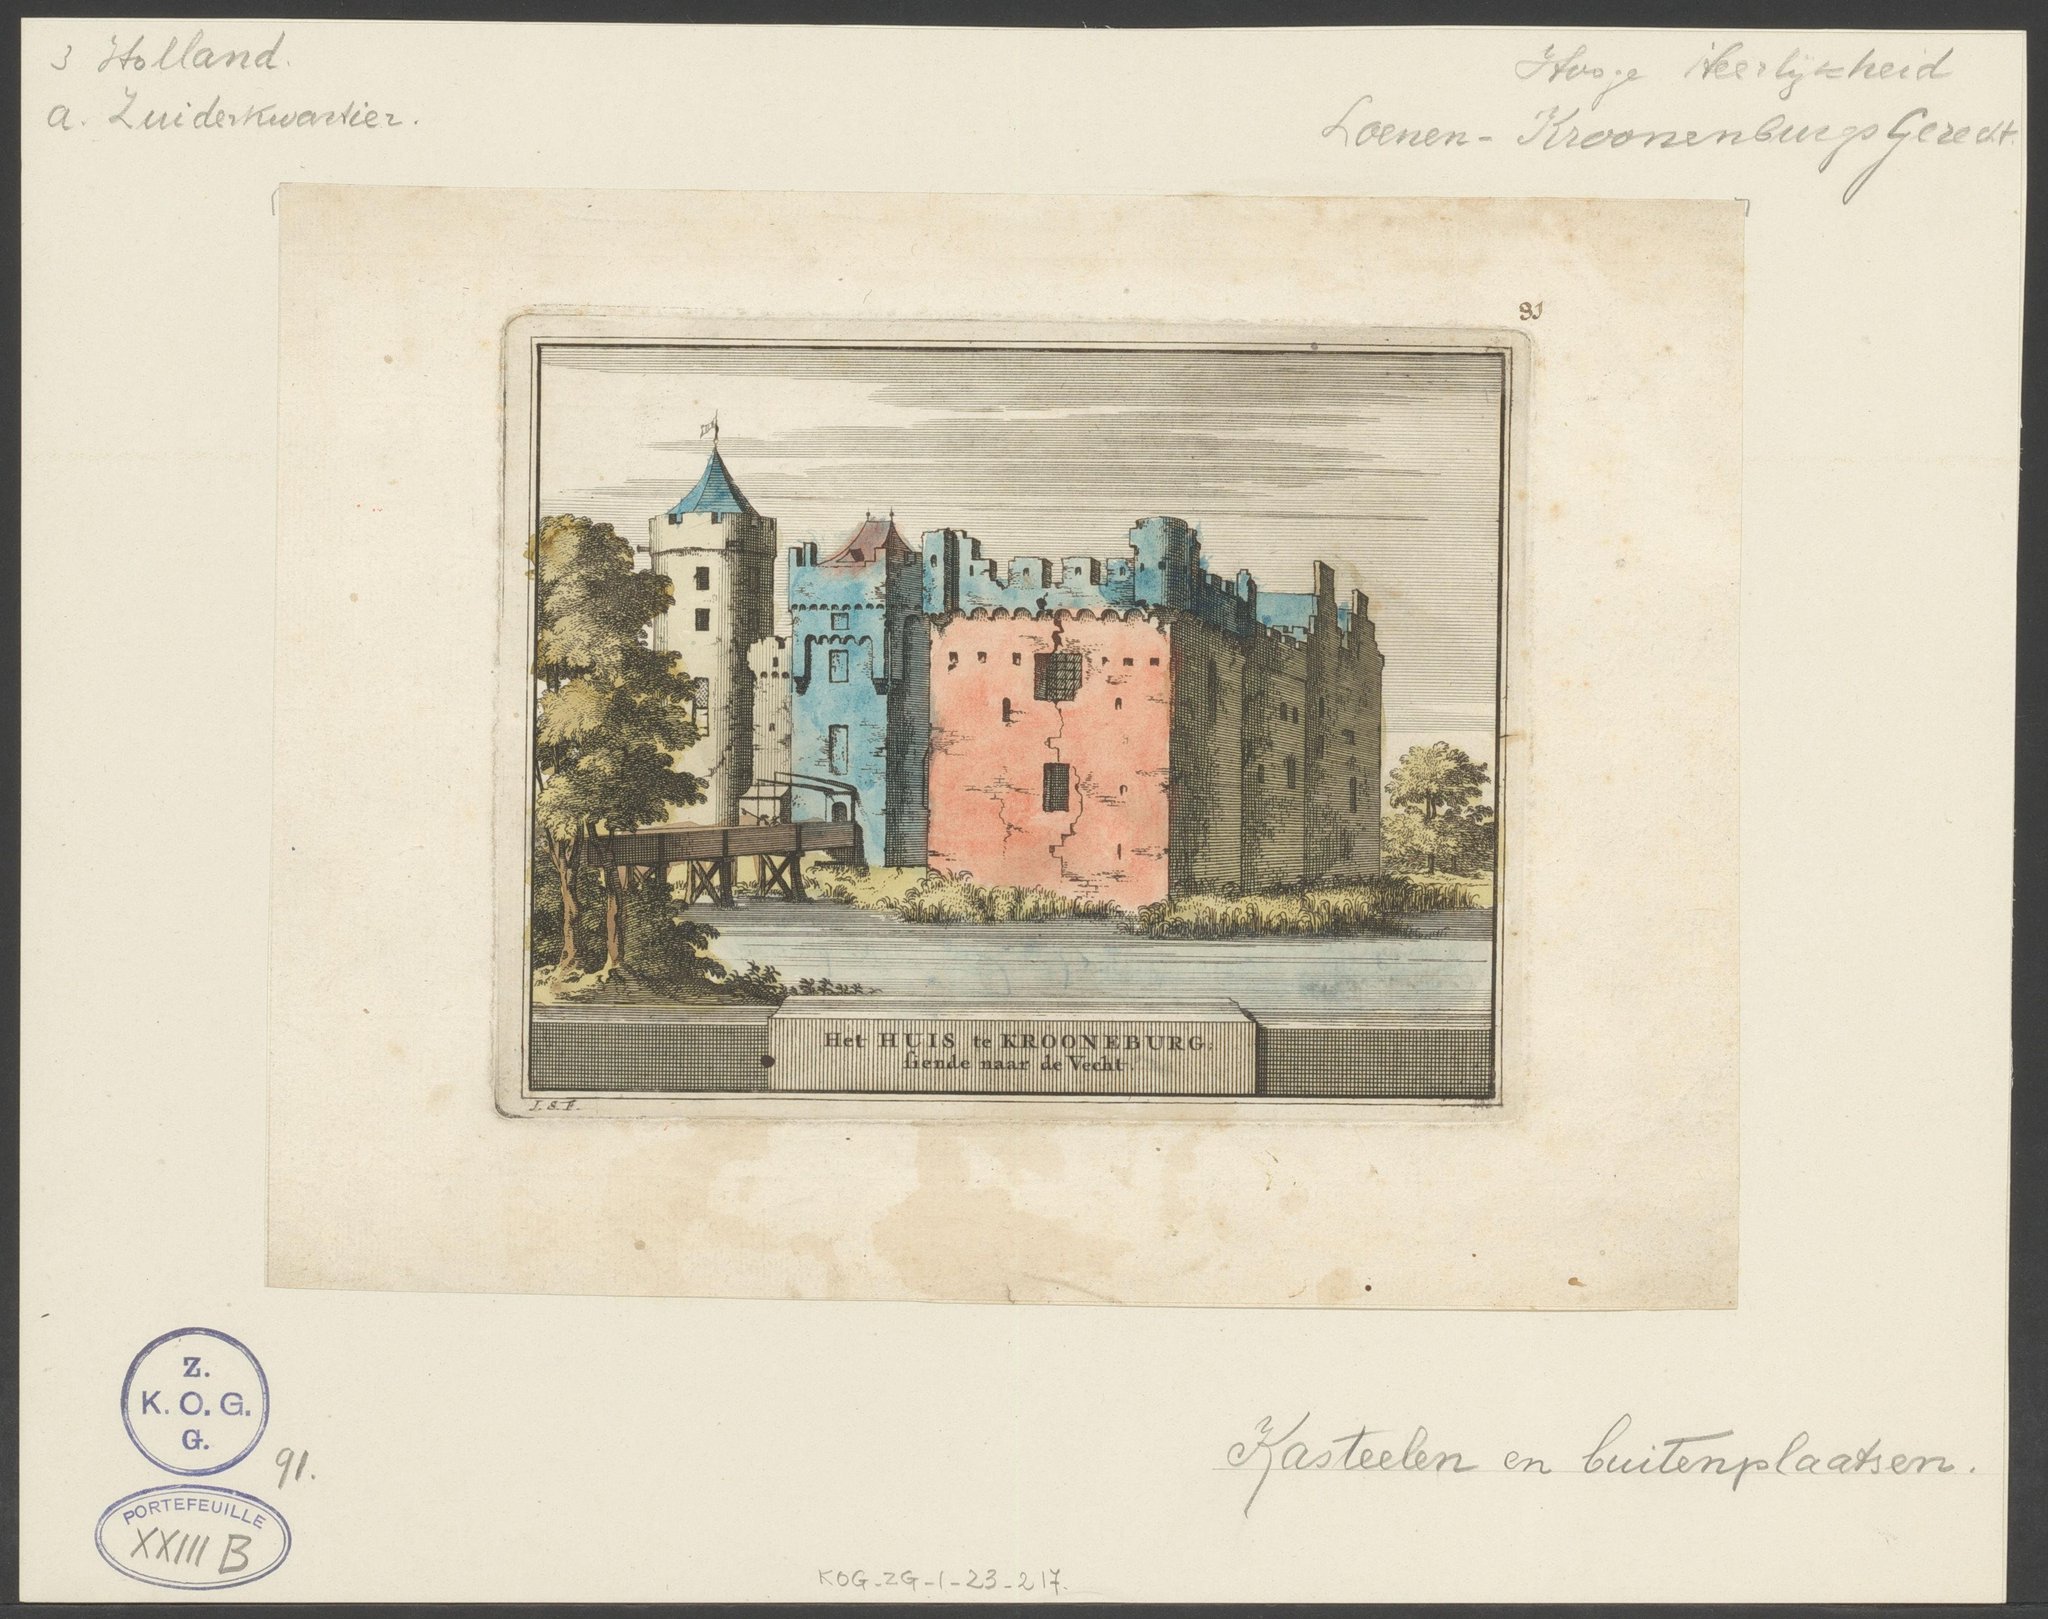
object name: print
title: Gezicht op Huis Kronenburg te Loenen aan de Vecht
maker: jacobus schijnvoet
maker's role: draughtsman, print maker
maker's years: 1685-1743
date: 1711-1774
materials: paper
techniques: engraving, etching, hand coloring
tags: castle, ruin of a dwelling, house, castle, etc.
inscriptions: stamp, collector's mark: Lugt 1641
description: Prent mogelijk uit: Smids, Ludolph. Schatkamer der Nederlandsche oudheden of woordenboek, behelsende Nederlands steden en dorpen, kasteelen (...). Amsterdam: Pieter de Coup, 1711. Verscheen tevens in de heruitgave van voorgenoemd werk in 1737 en 1774. In 1721 verscheen er een uitgave met alleen de prenten: Nederlandsche oudheden, bestaande in zestig verbeeldingen (...) gelegen in Holland, 't Sticht van Utrecht en Gelderland enz. Amsterdam: Hendrik Bosch, 1721.